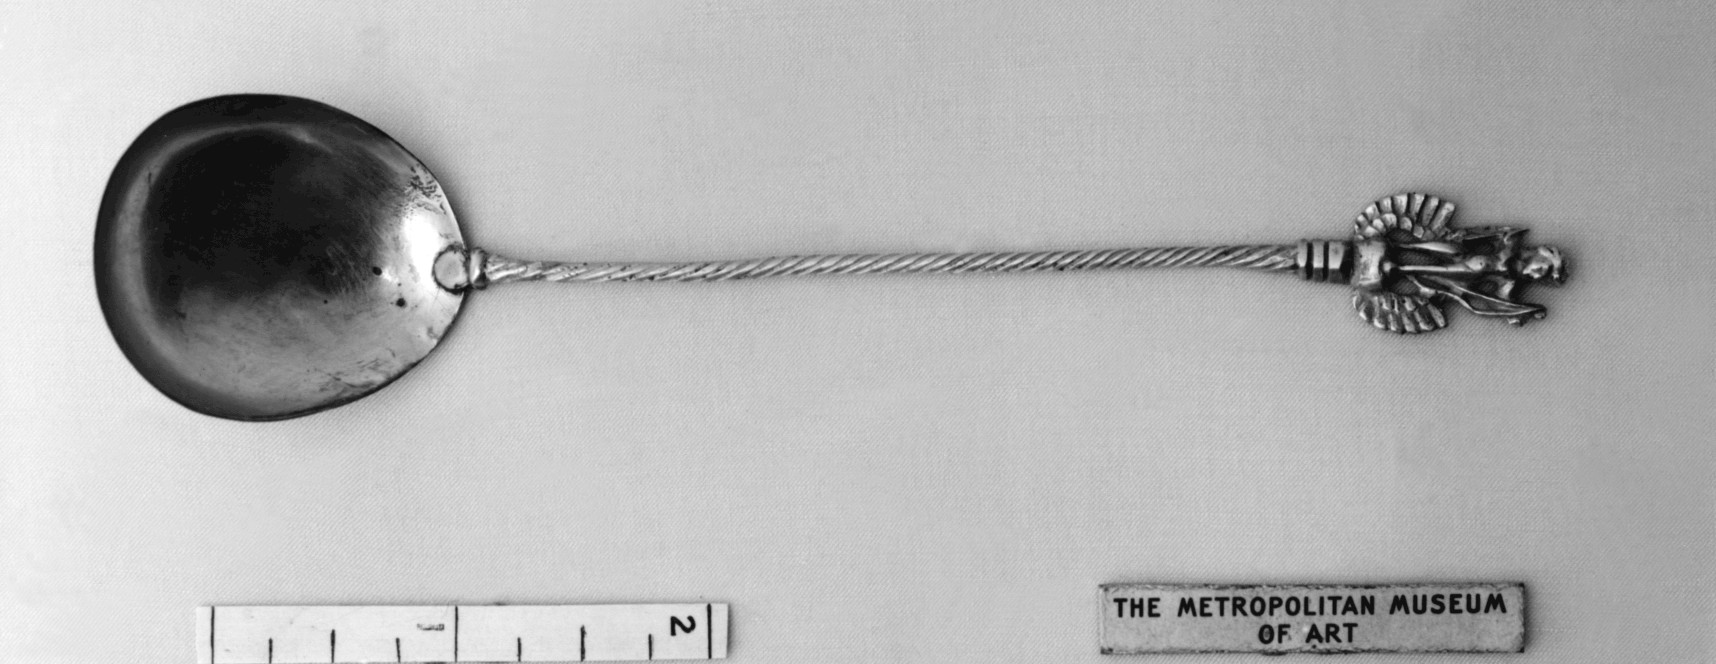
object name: spoon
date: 1701-1800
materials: gilt, silver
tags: bow and arrow,male nudes